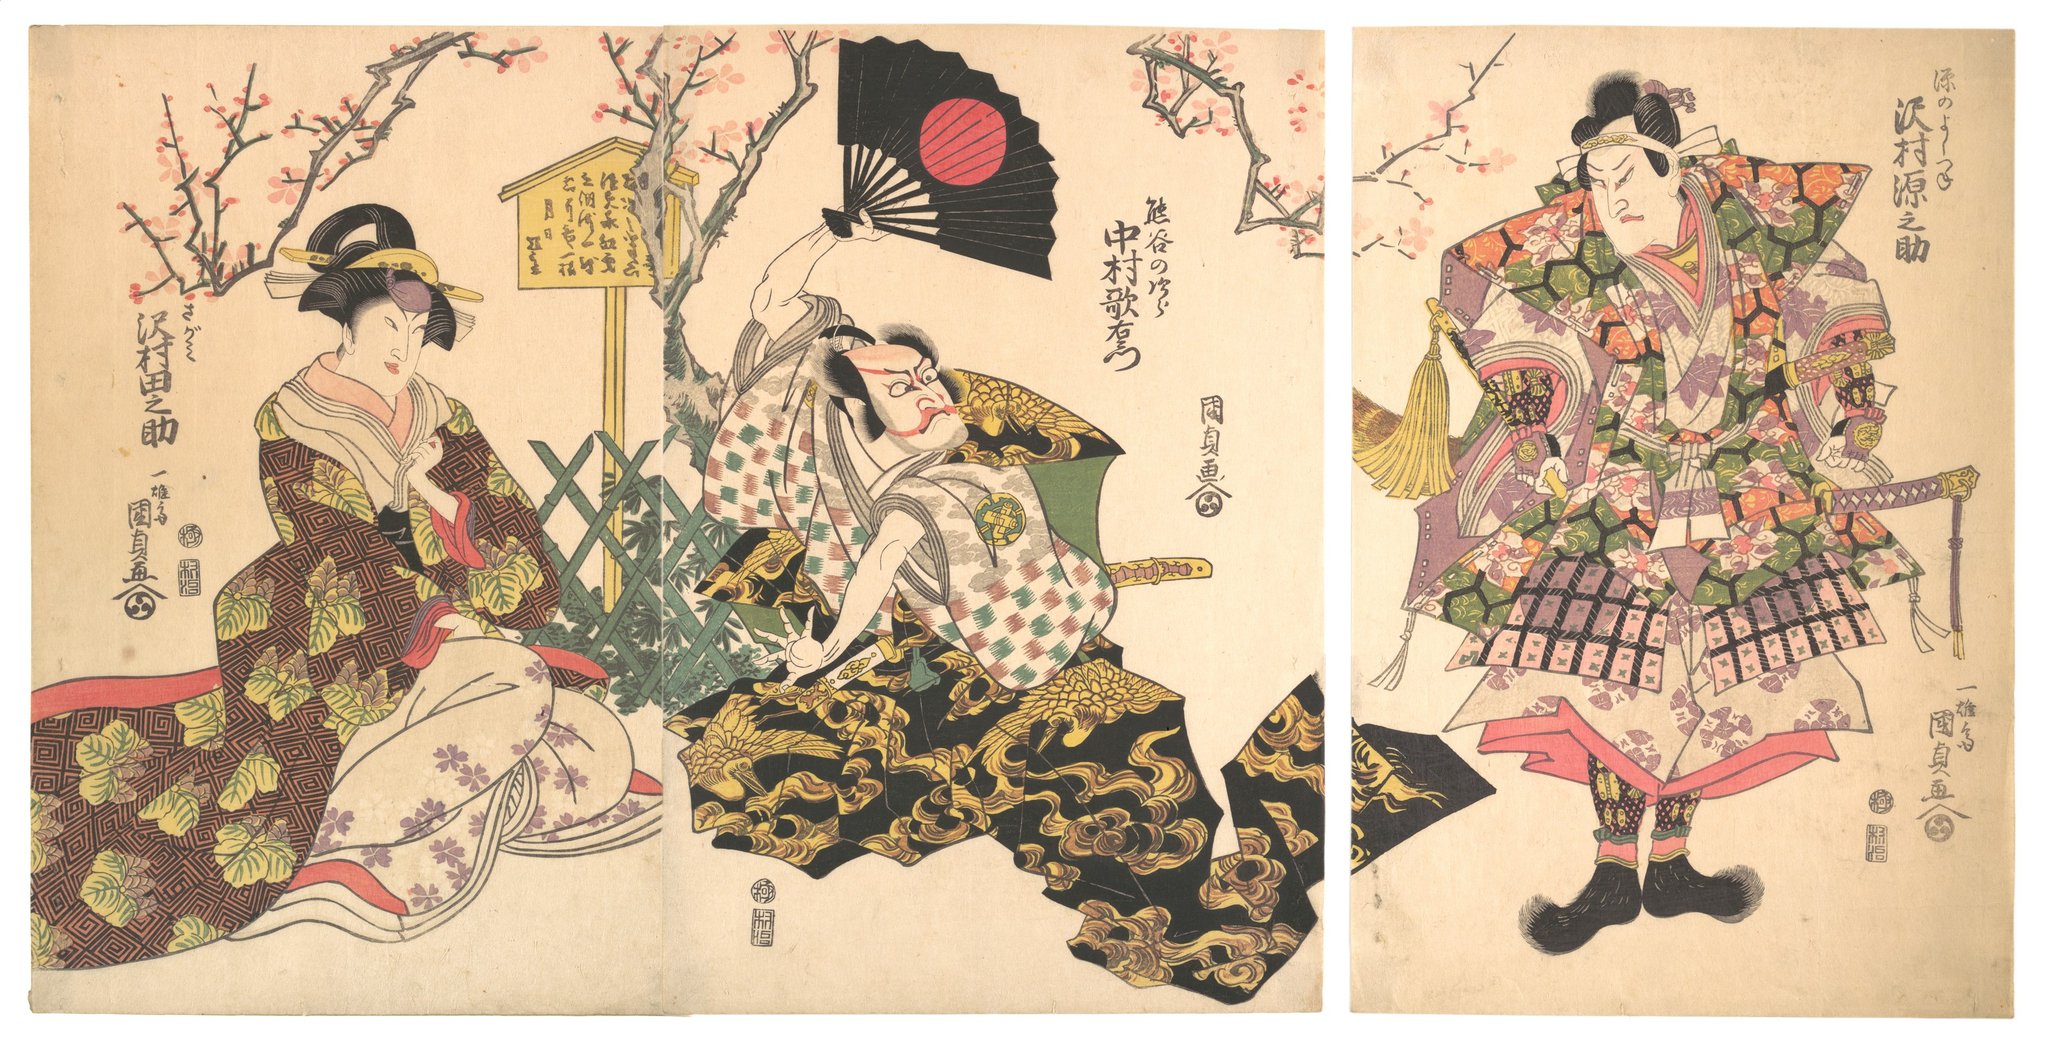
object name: print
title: Kabuki Scene at Kumagai's Camp, from the play The Chronicle of the Battle of Ichinotani (Ichinotani futaba gunki)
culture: japanese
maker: utagawa kunisada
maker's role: artist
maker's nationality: japanese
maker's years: 1786-1864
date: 1811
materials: ink, paper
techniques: woodblock print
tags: fans,women,actors